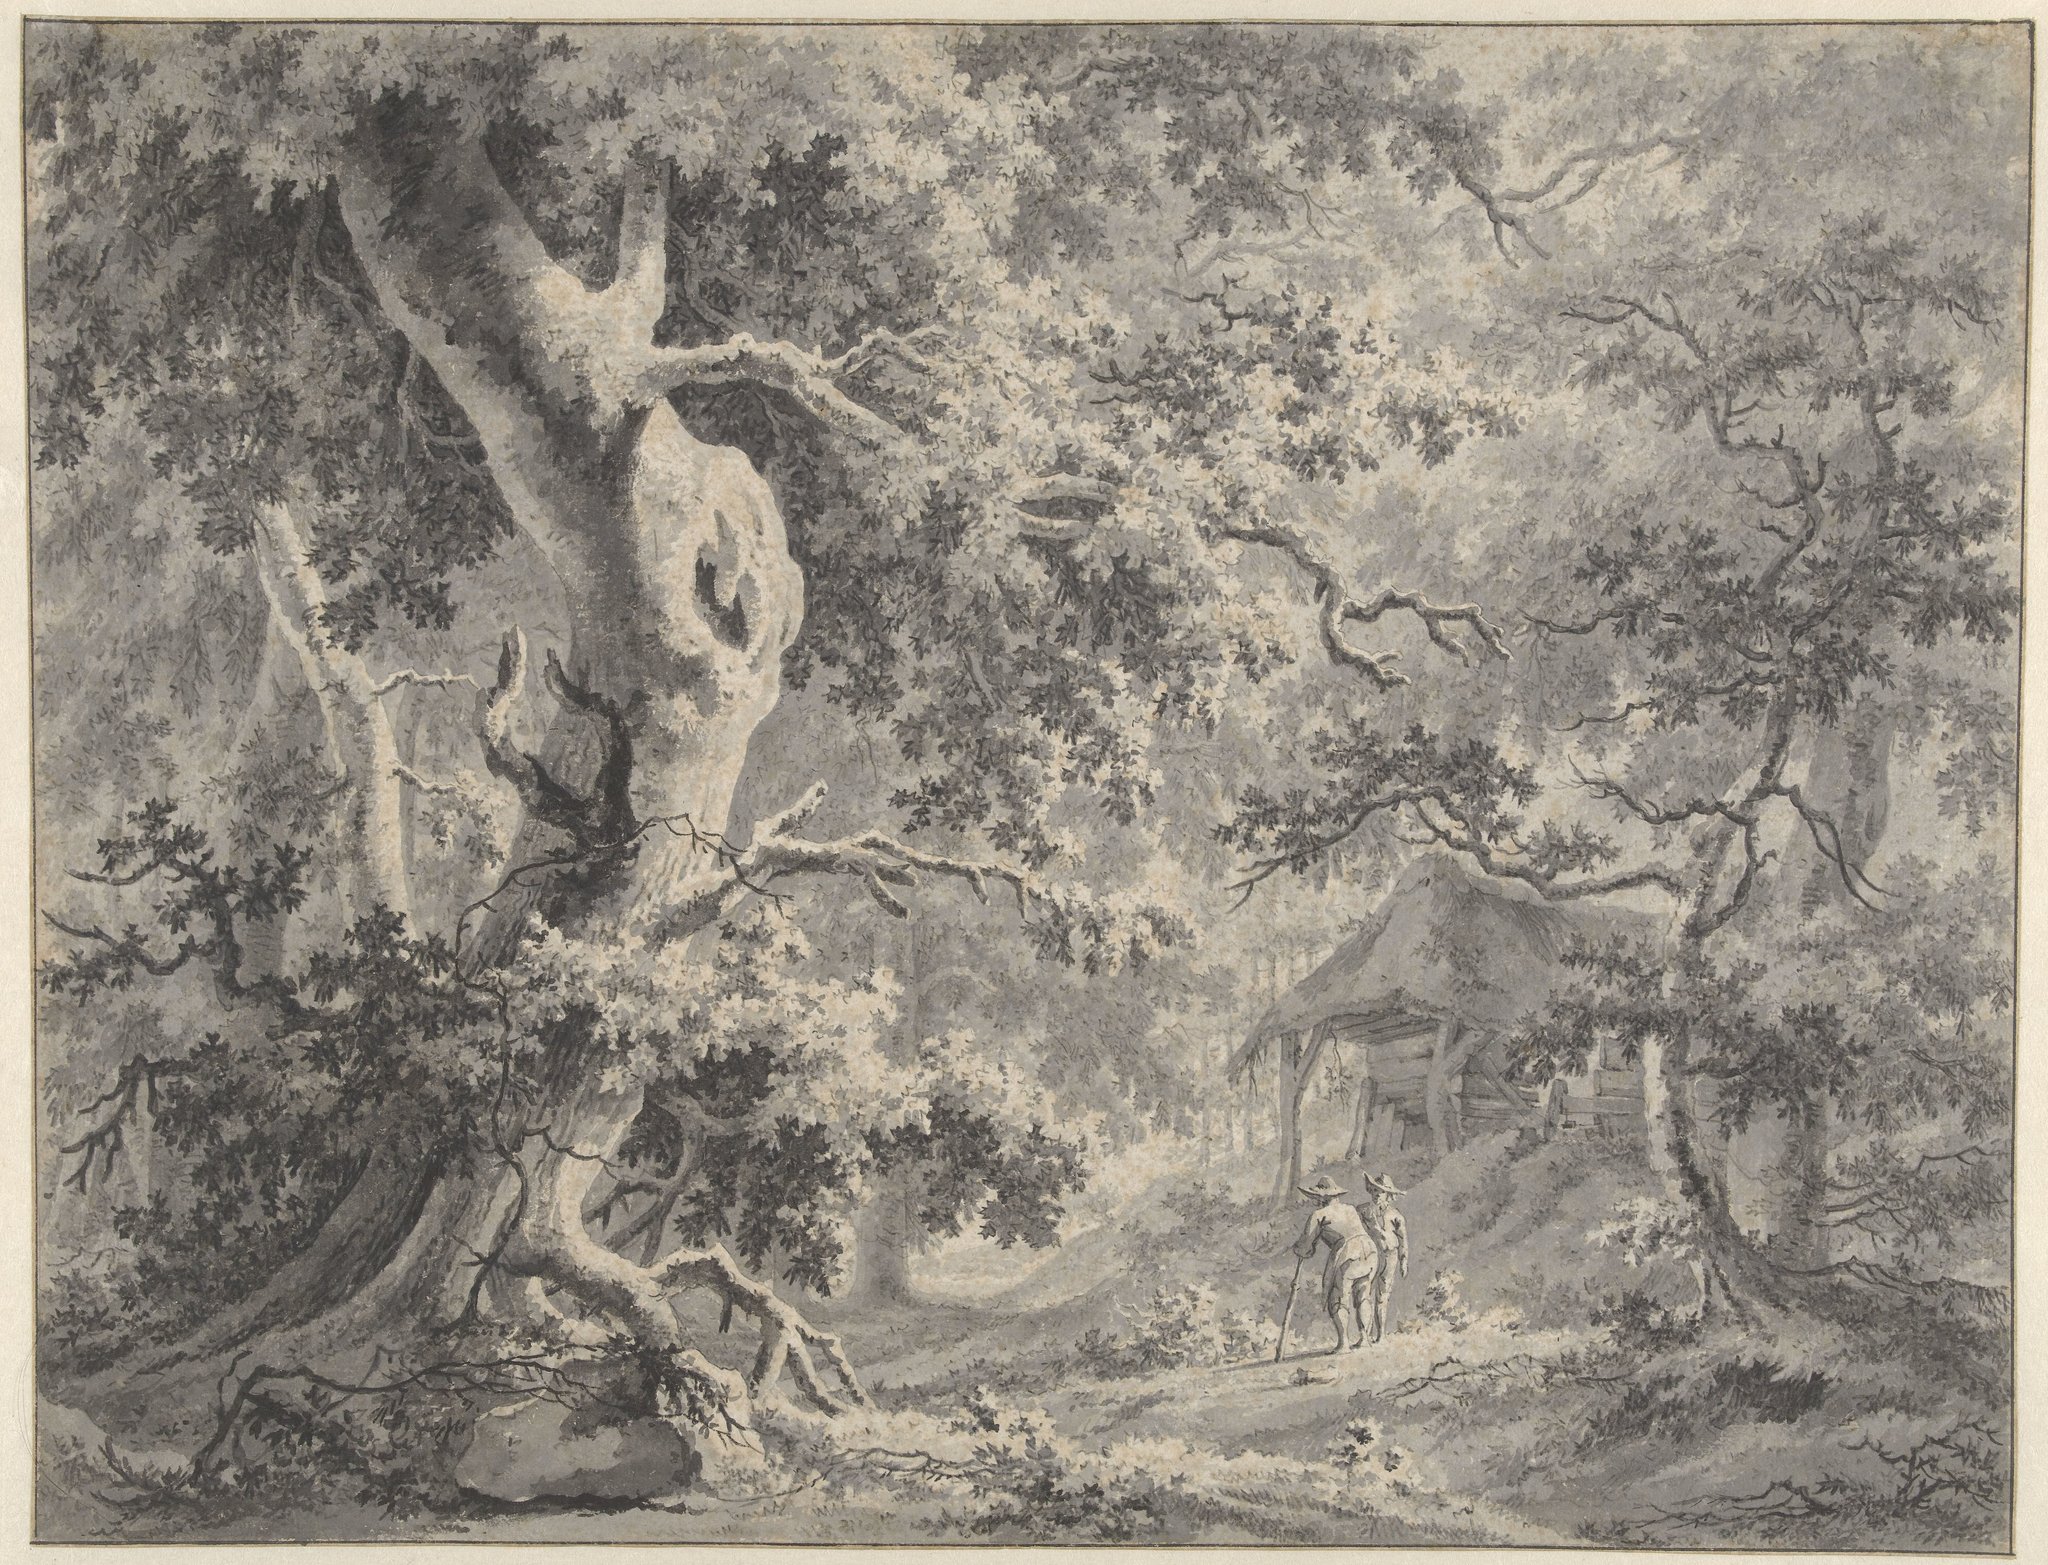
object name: drawing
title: Bosgezicht met twee figuren bij een hut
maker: paulus van liender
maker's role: draughtsman, print maker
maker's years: 1731-1797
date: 1741-1797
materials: chalk, paper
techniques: brush